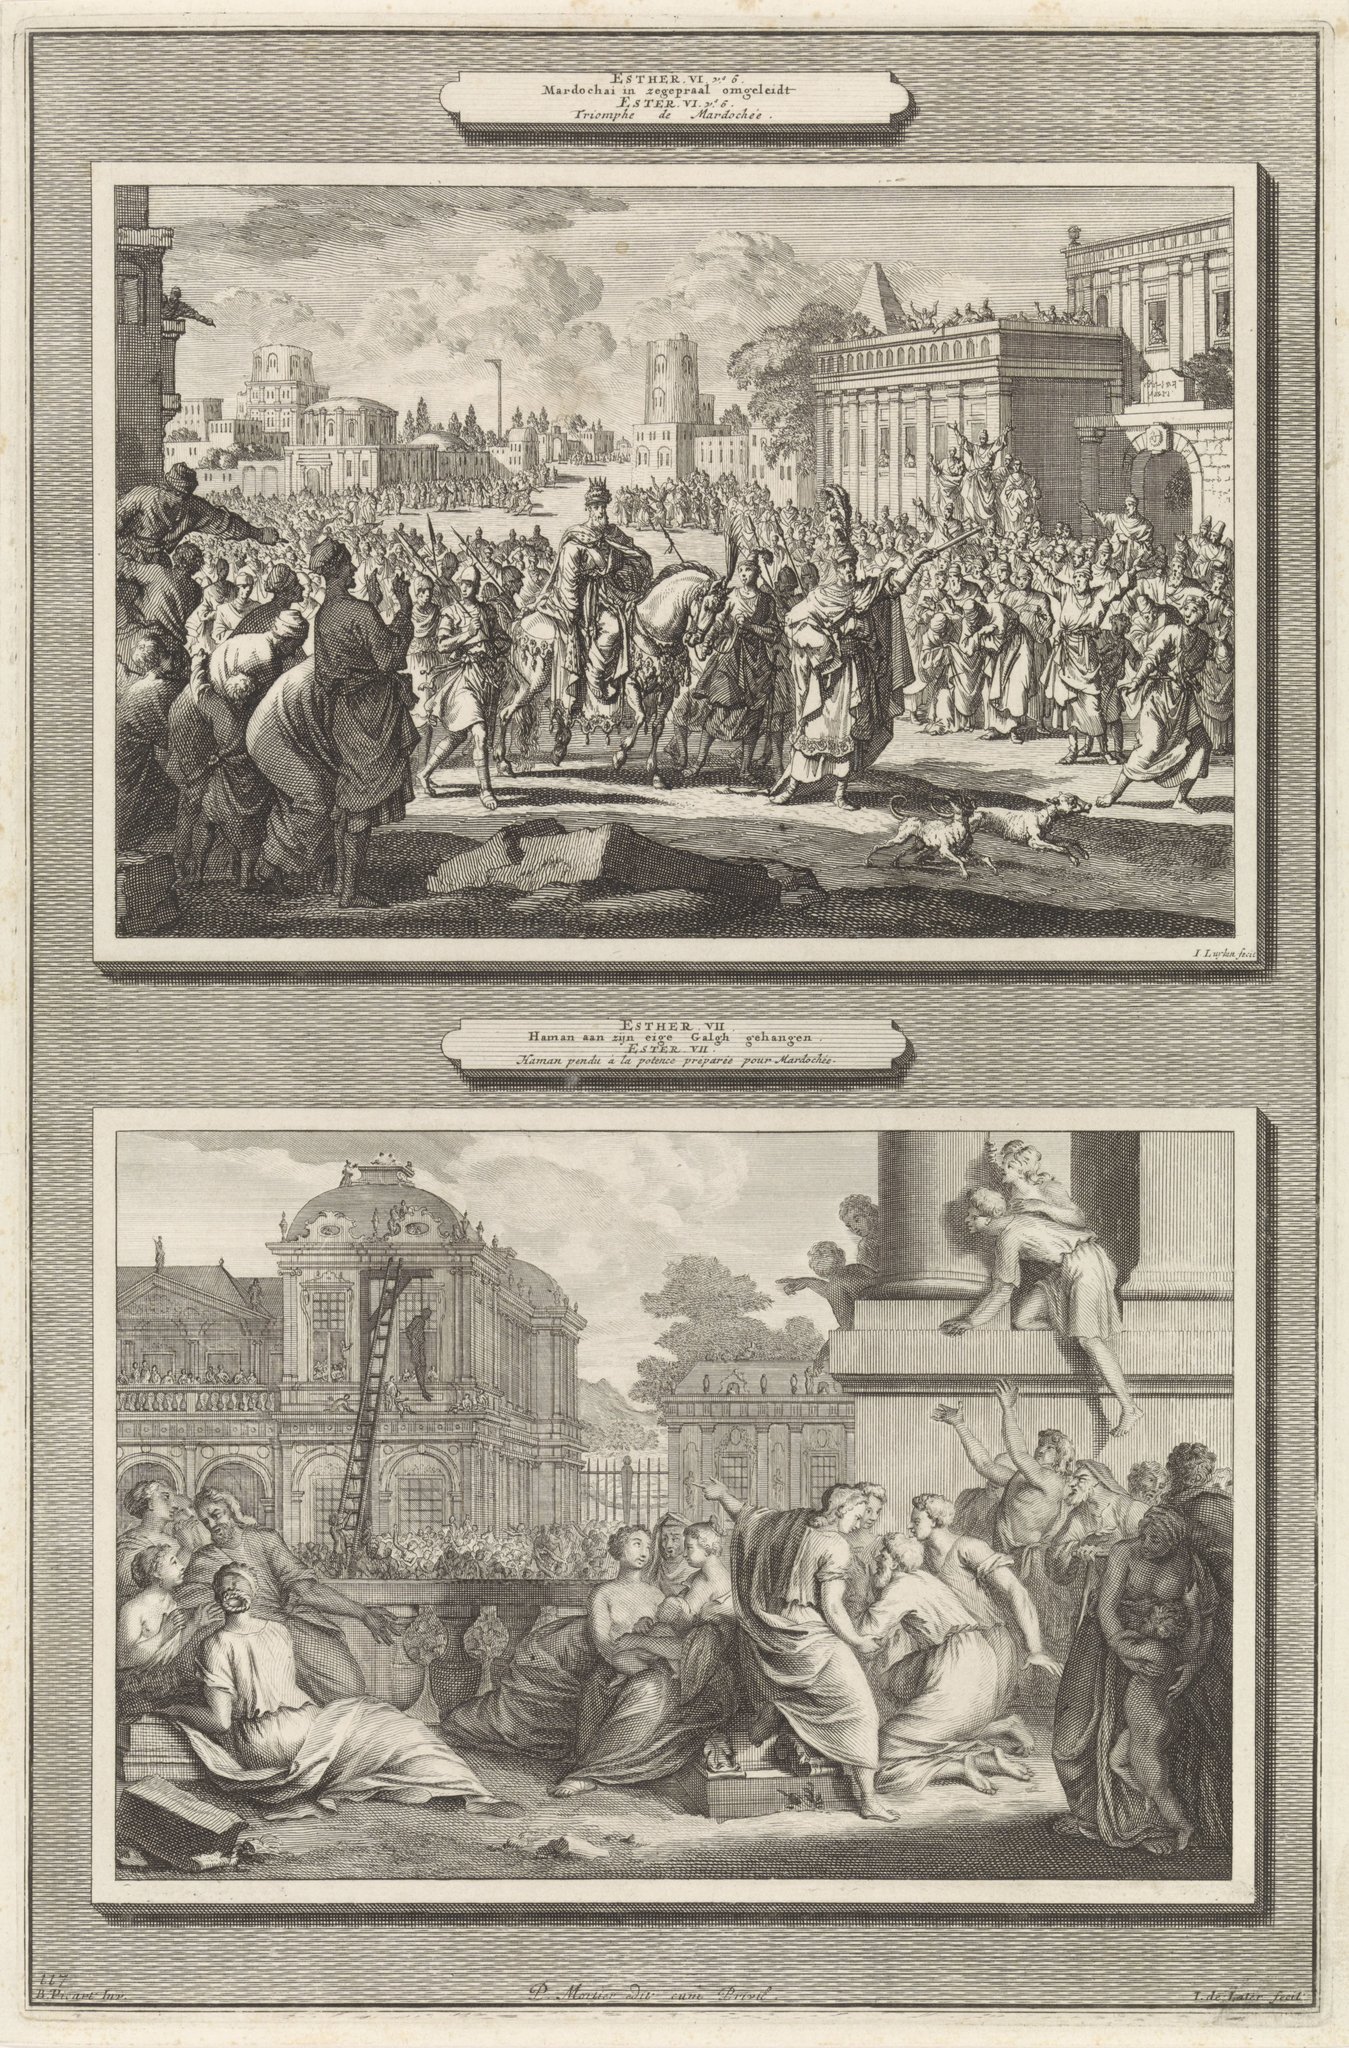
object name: book illustration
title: Esther VI vs. 6: Mordechai in zegepraal omgeleidt / Esther VII: Haman aan zijn eige Galgh gehangen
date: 1700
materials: paper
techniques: etching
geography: amsterdam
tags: mordecai's triumph: mordecai, mounted on the king's horse, is led through the city by haman (esther and ahasuerus may be looking on from the palace), haman on the gallows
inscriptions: collector's mark: Lugt 2228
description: Twee voorstellingen op een plaat. Boven: Mordechai zit op een paard en draagt een prachtig gewaad. Hij wordt door soldaten door de straten van Babylon begeleid, terwijl de mensen hem toejuichen. Haman leidt de praalstoet. Onder: Haman hangt opgeknoopt aan de galg die hij zelf had opgetrokken. Rondom de galg staan toeschouwers naar de executie te kijken.